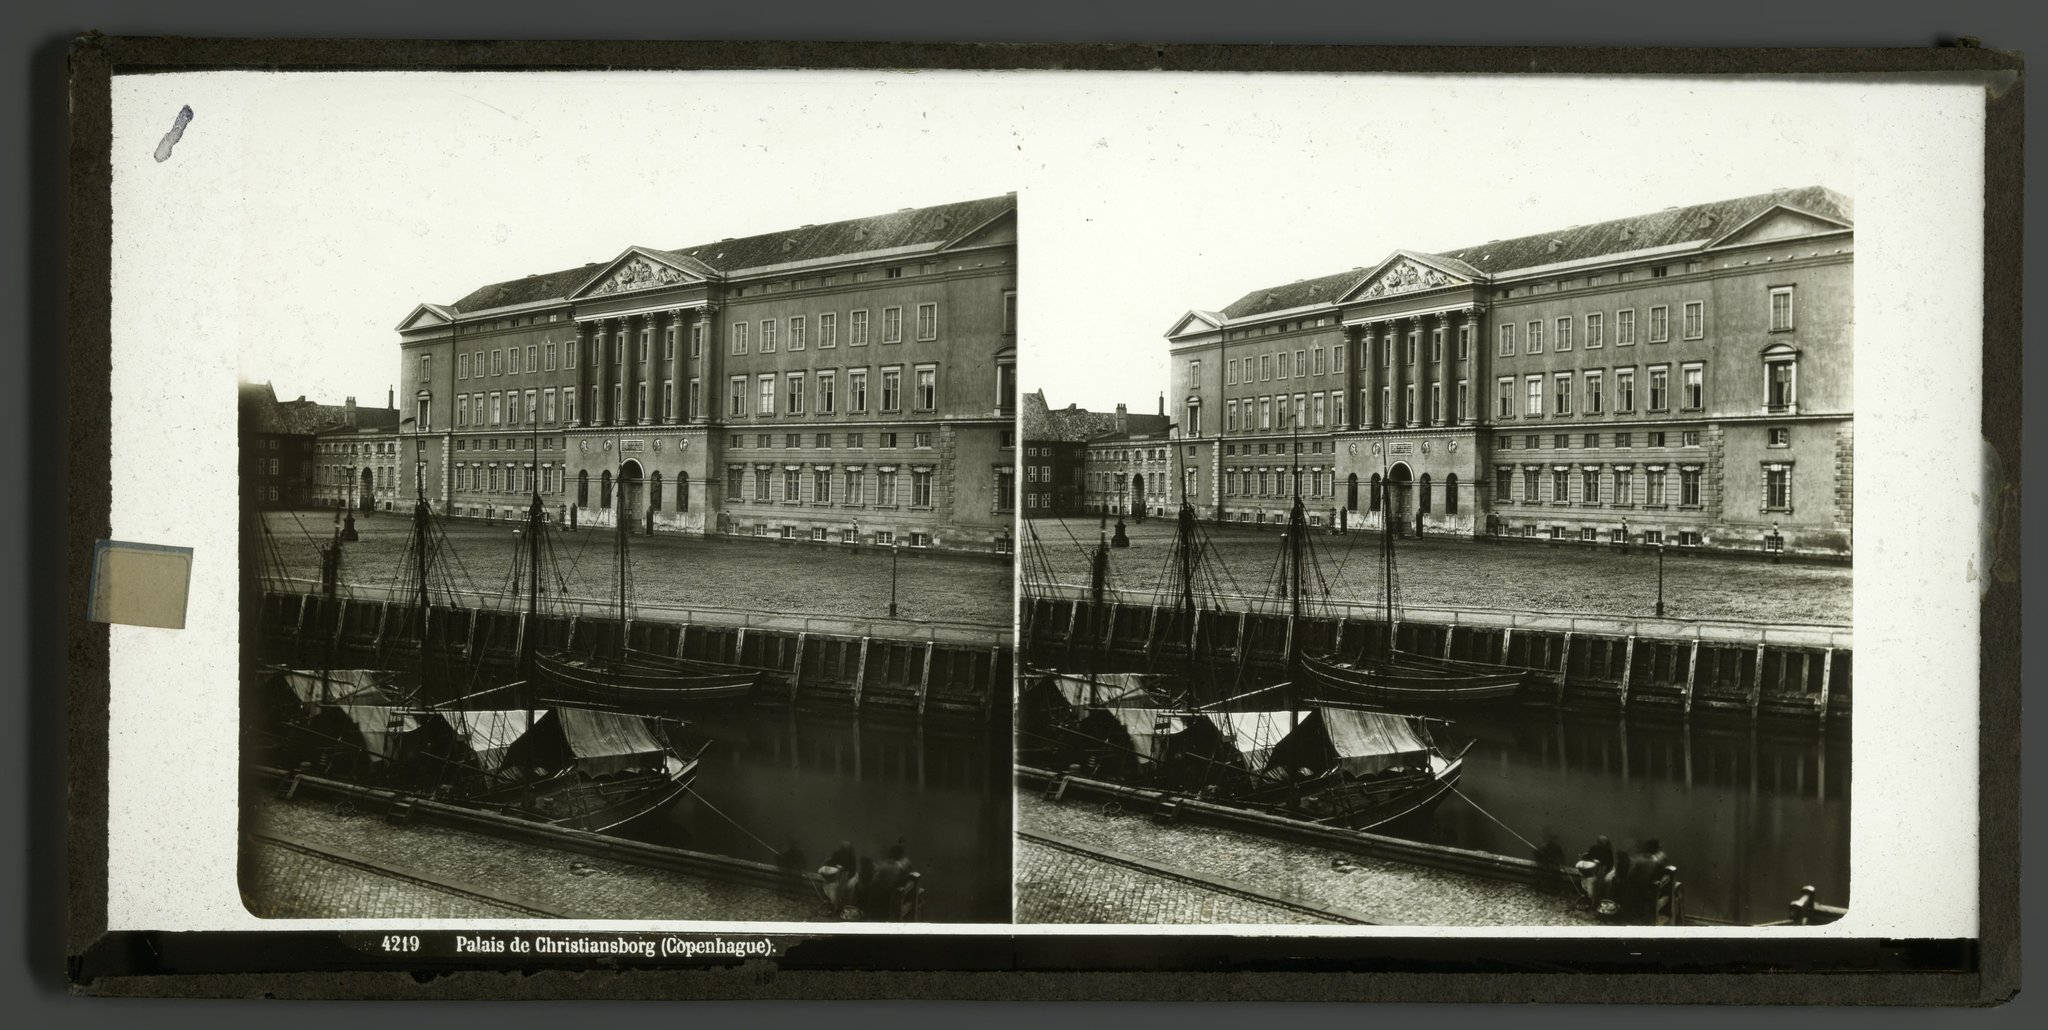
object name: stereoscopic photograph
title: Gezicht op Christiansborg te Kopenhagen, Denemarken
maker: Anonymous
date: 1860-1890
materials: glass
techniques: slide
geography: copenhagen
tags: palace, exterior ~ representation of a building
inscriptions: number: ‘4219’